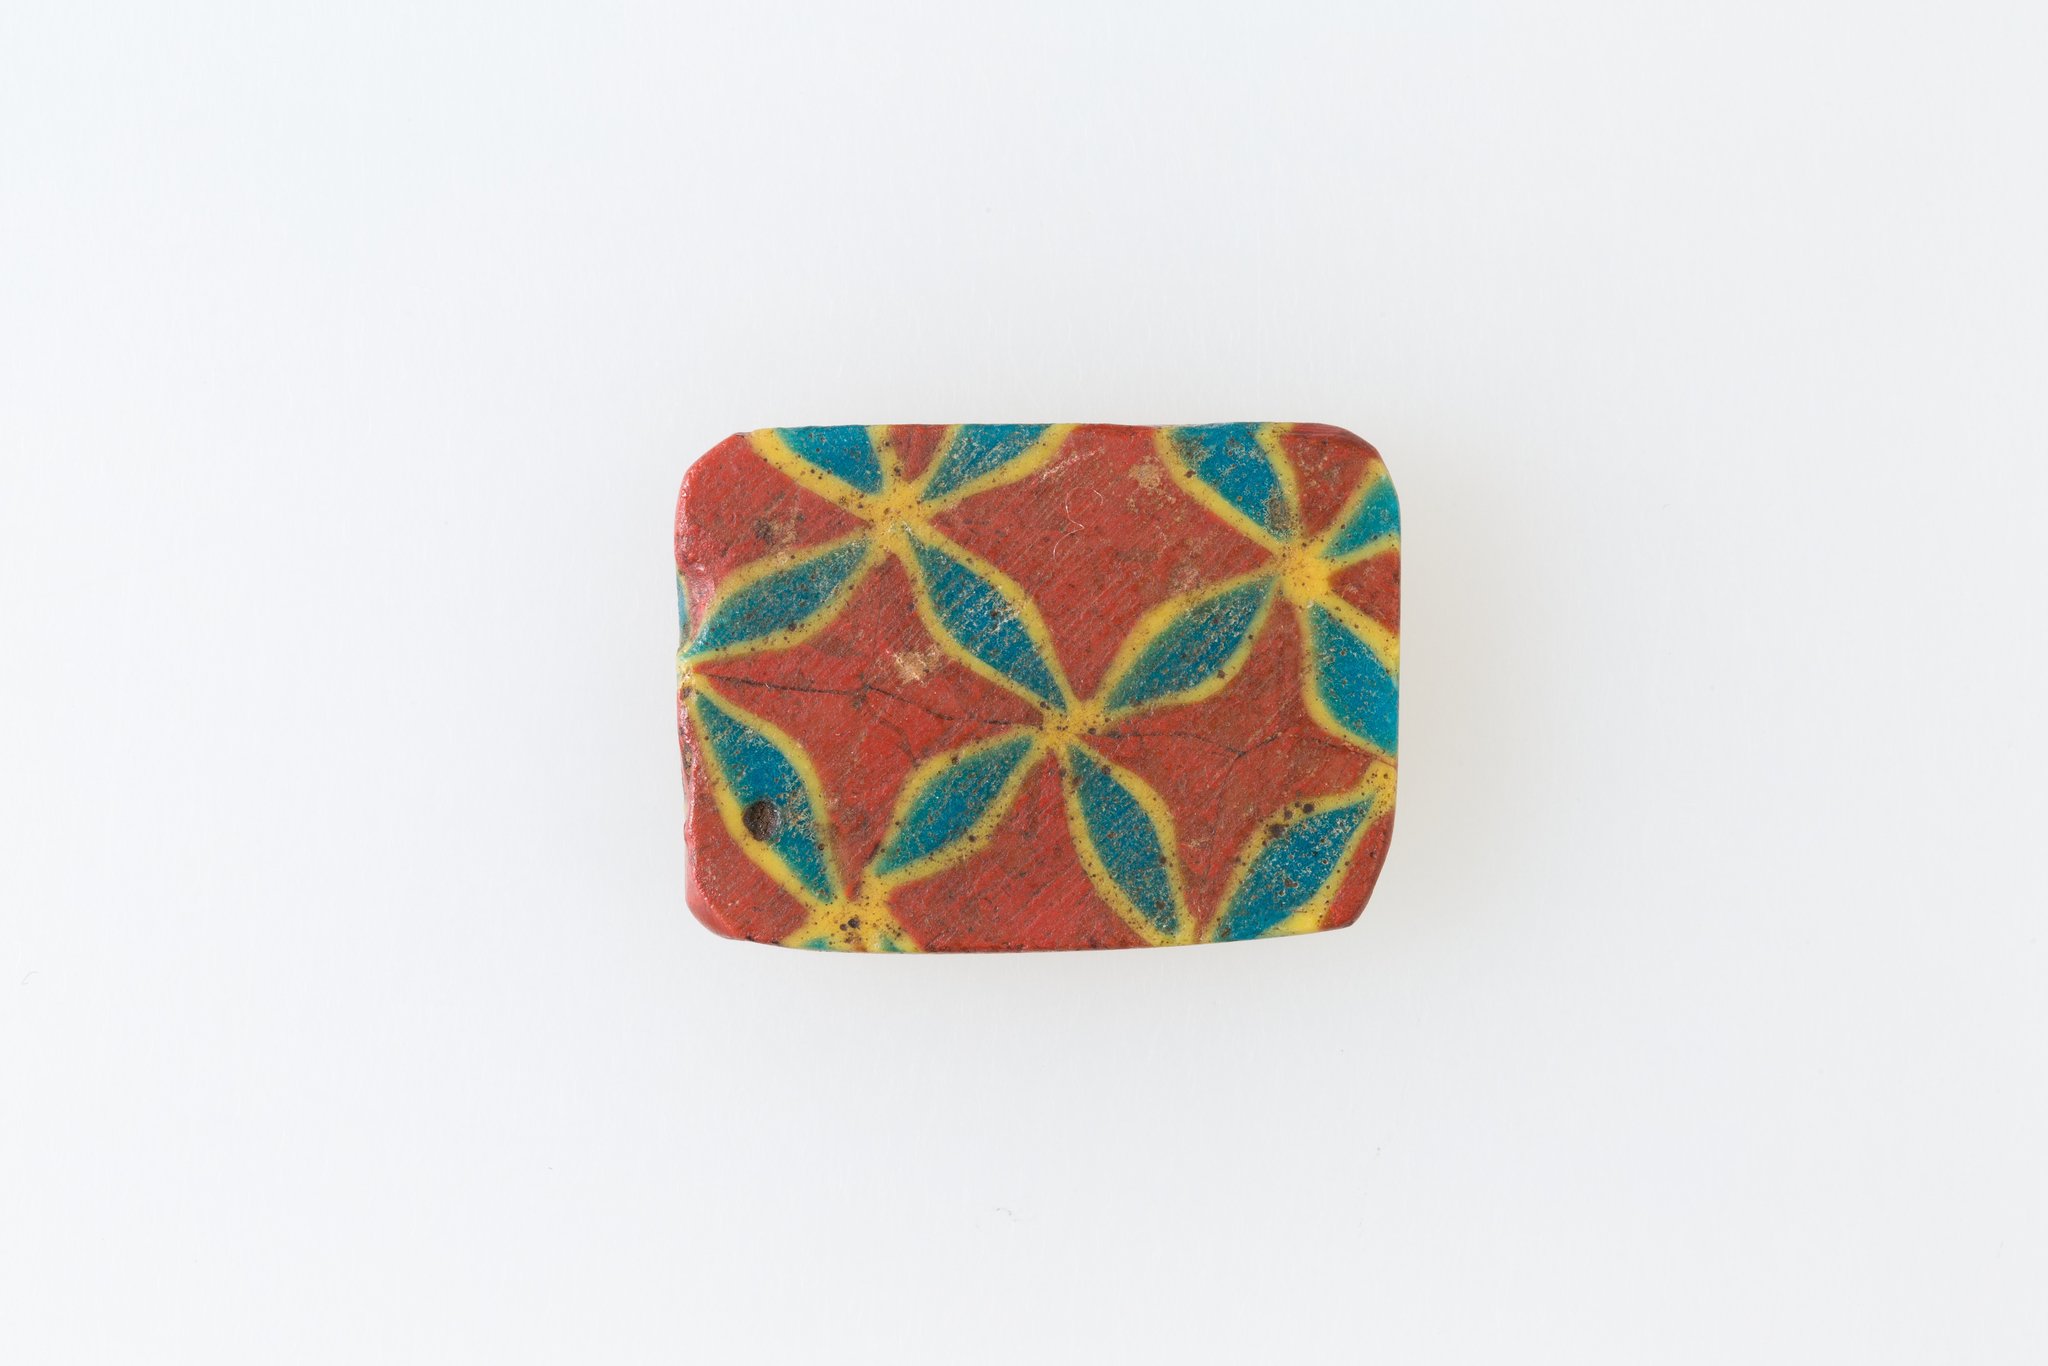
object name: inlay fragment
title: Inlay fragment, net design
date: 1-300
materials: glass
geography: egypt